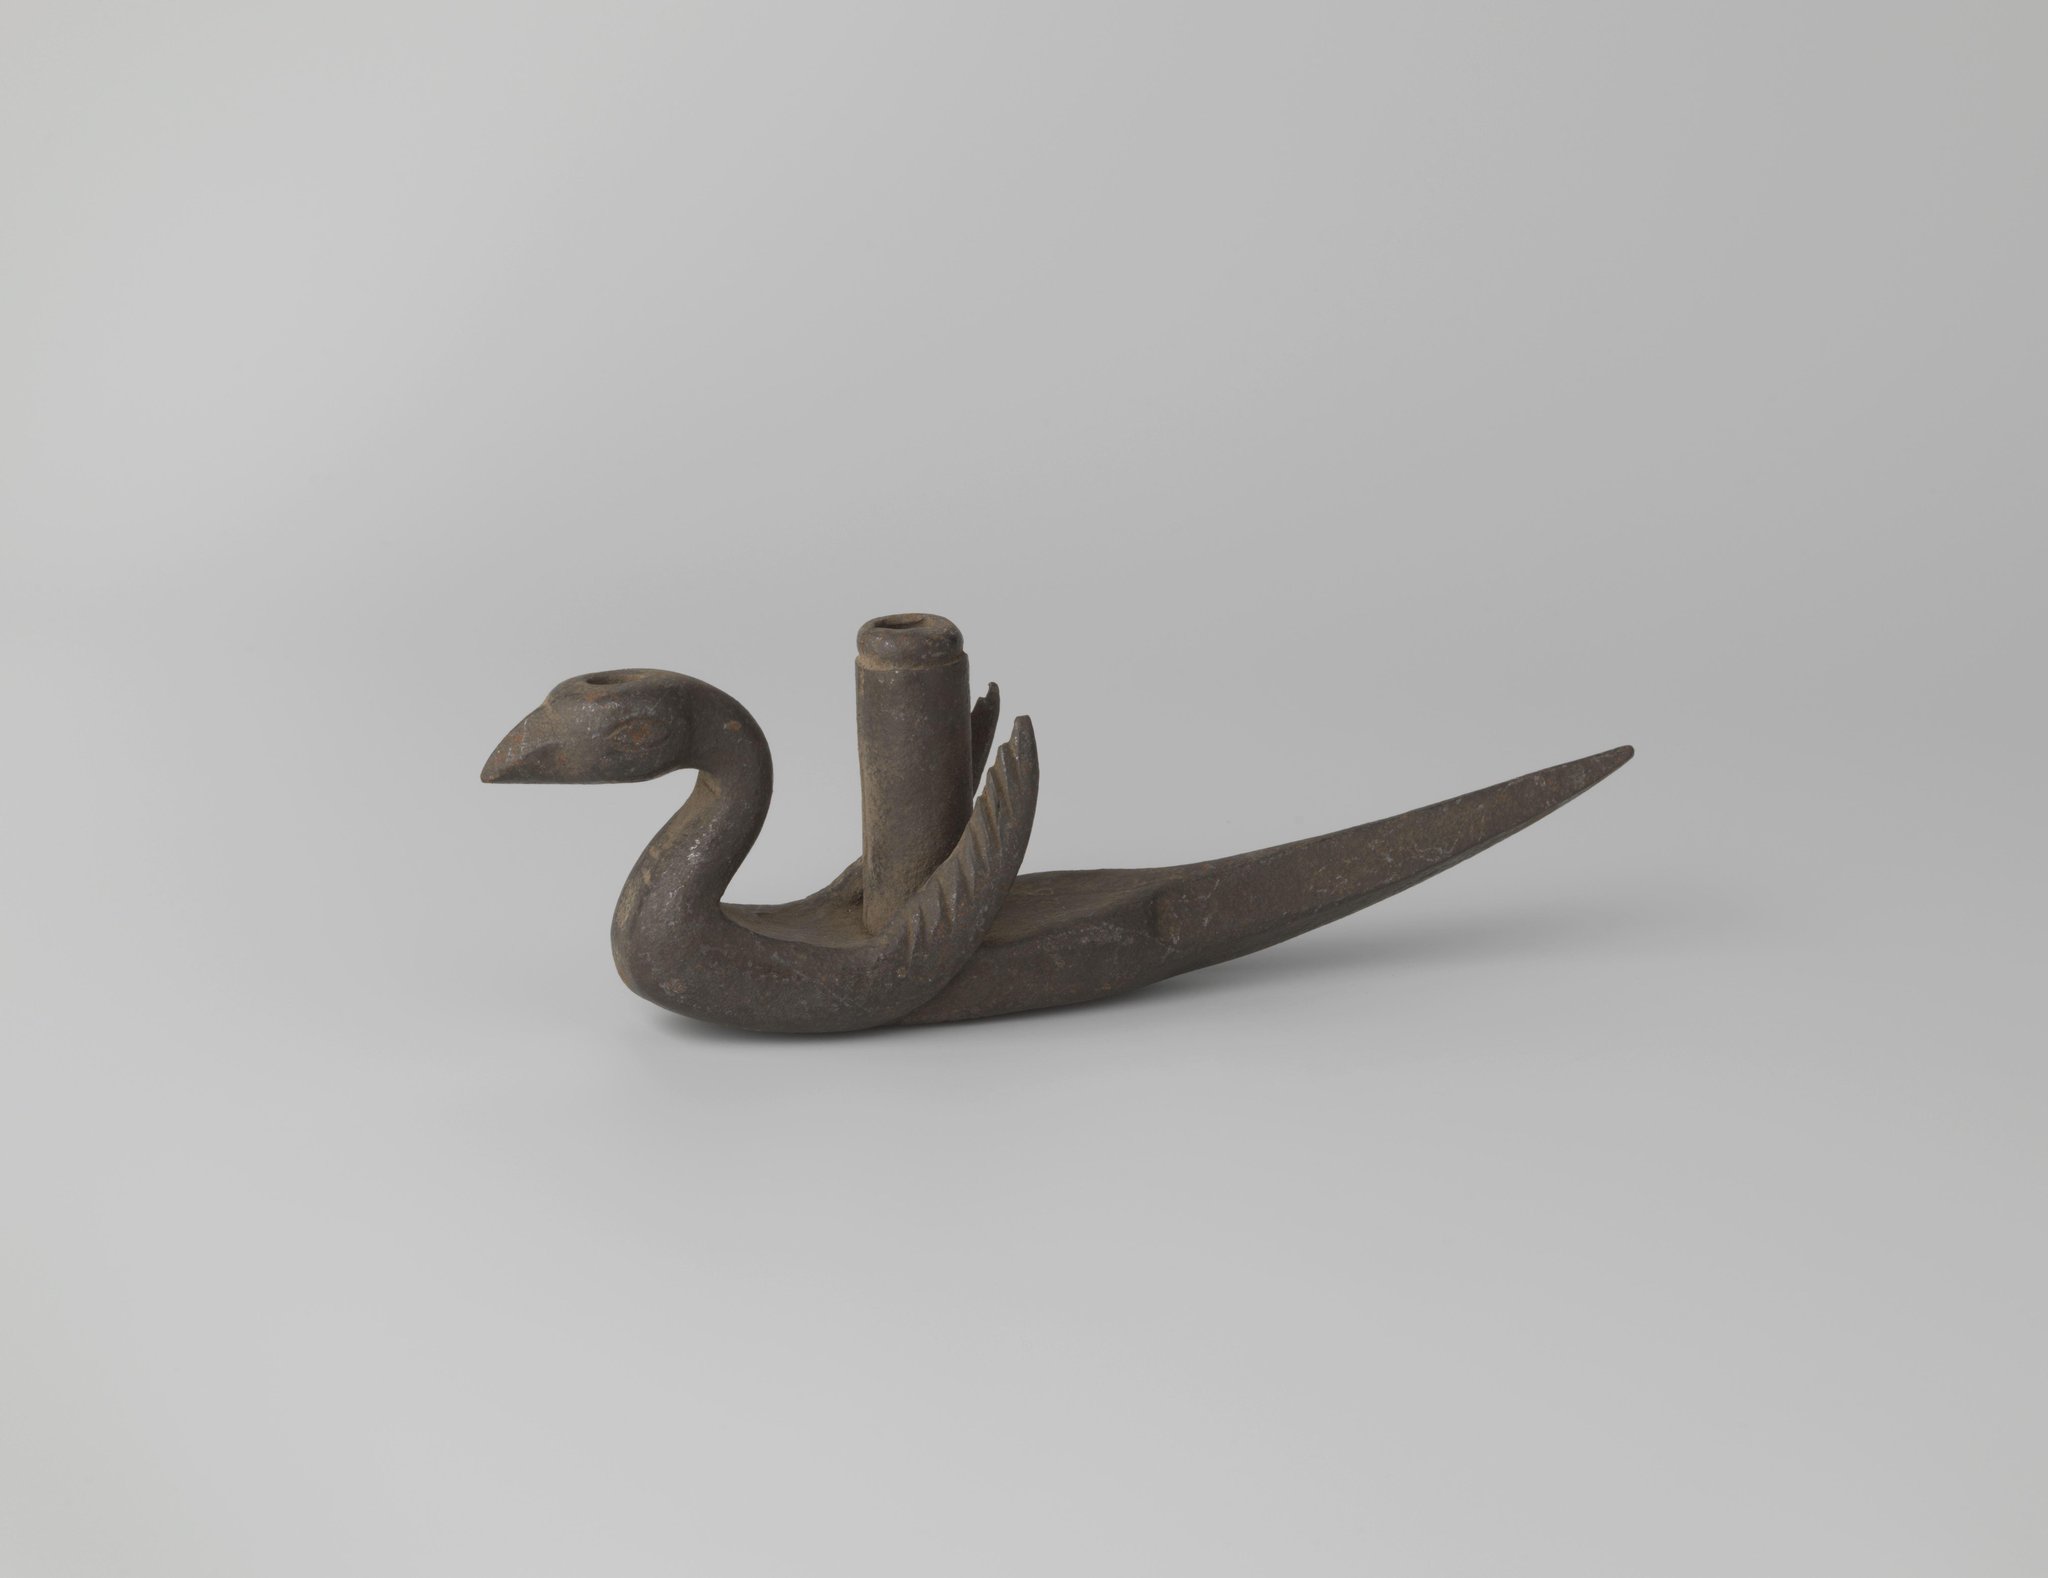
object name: decoratief object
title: Zwaan van ijzer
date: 1400-1950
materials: iron